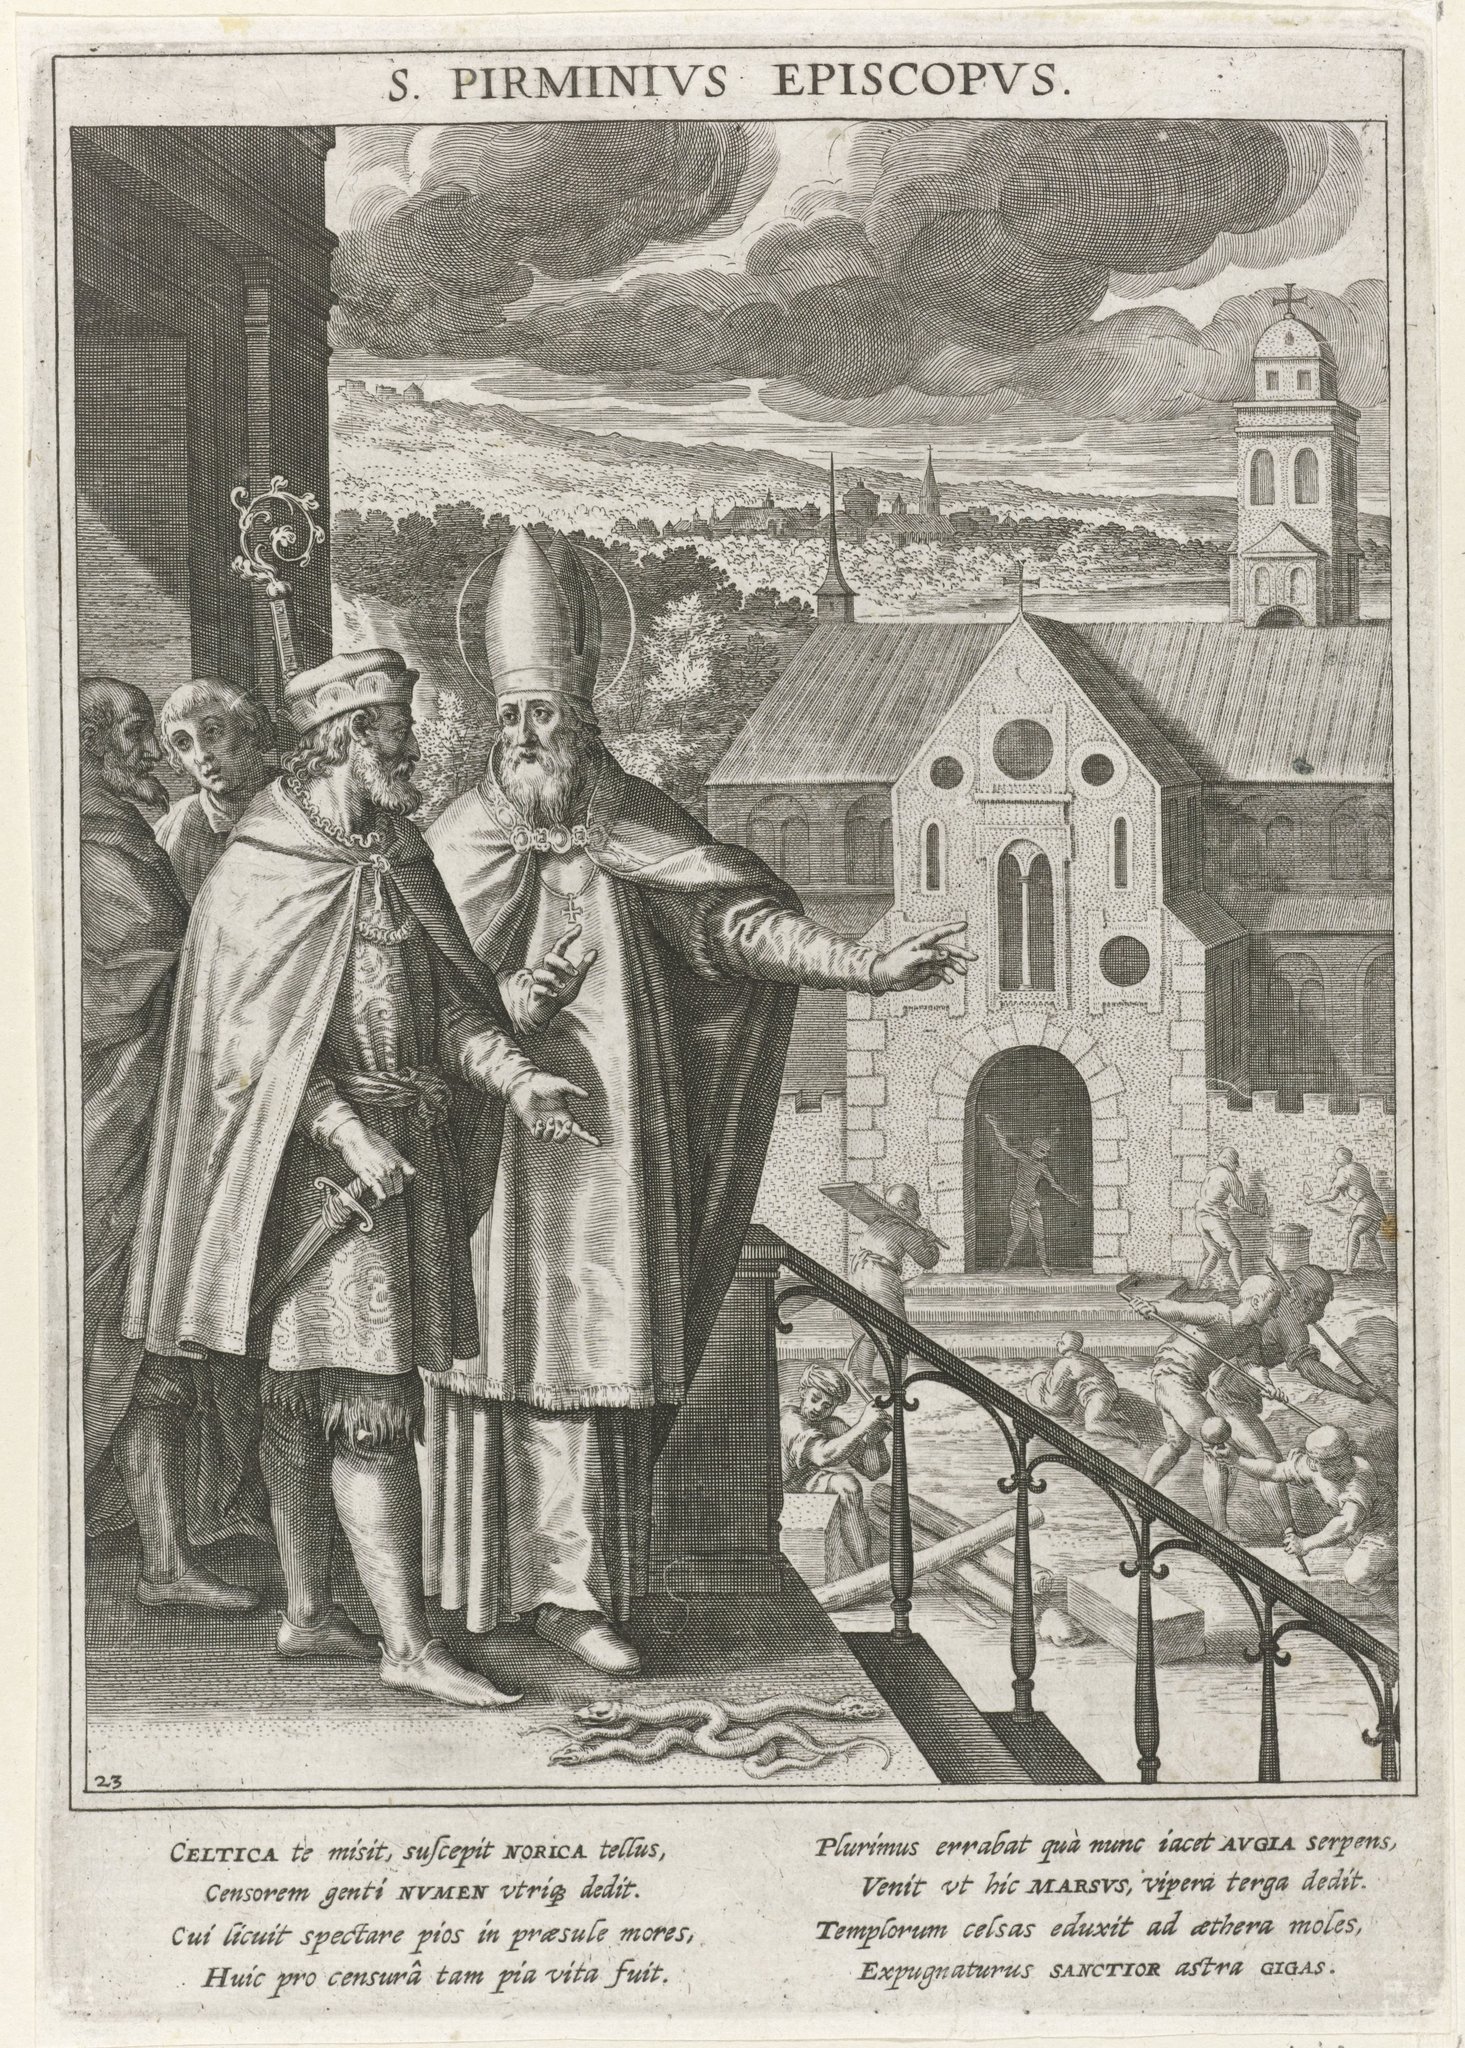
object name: print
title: Heilige Pirminius toont Karel Martel de bouw van de abdij van Reichenau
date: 1615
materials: paper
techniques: engraving, etching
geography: munich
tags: building-site of church indicated by a miracle, male saints (with name), snakes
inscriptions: collector's mark: Lugt 240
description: Op de voorgrond de H. Pirminius, abt en bisschop van Reichenau. Hij toont Karel Martel de bouw van de abdij op het eiland Reichenau. Op de grond liggen slangen die werden verjaagd door de constructie van de abdij. De prent heeft een Latijns onderschrift en is de 23ste prent van een 60-delige serie met als onderwerp de heiligen van Beieren.